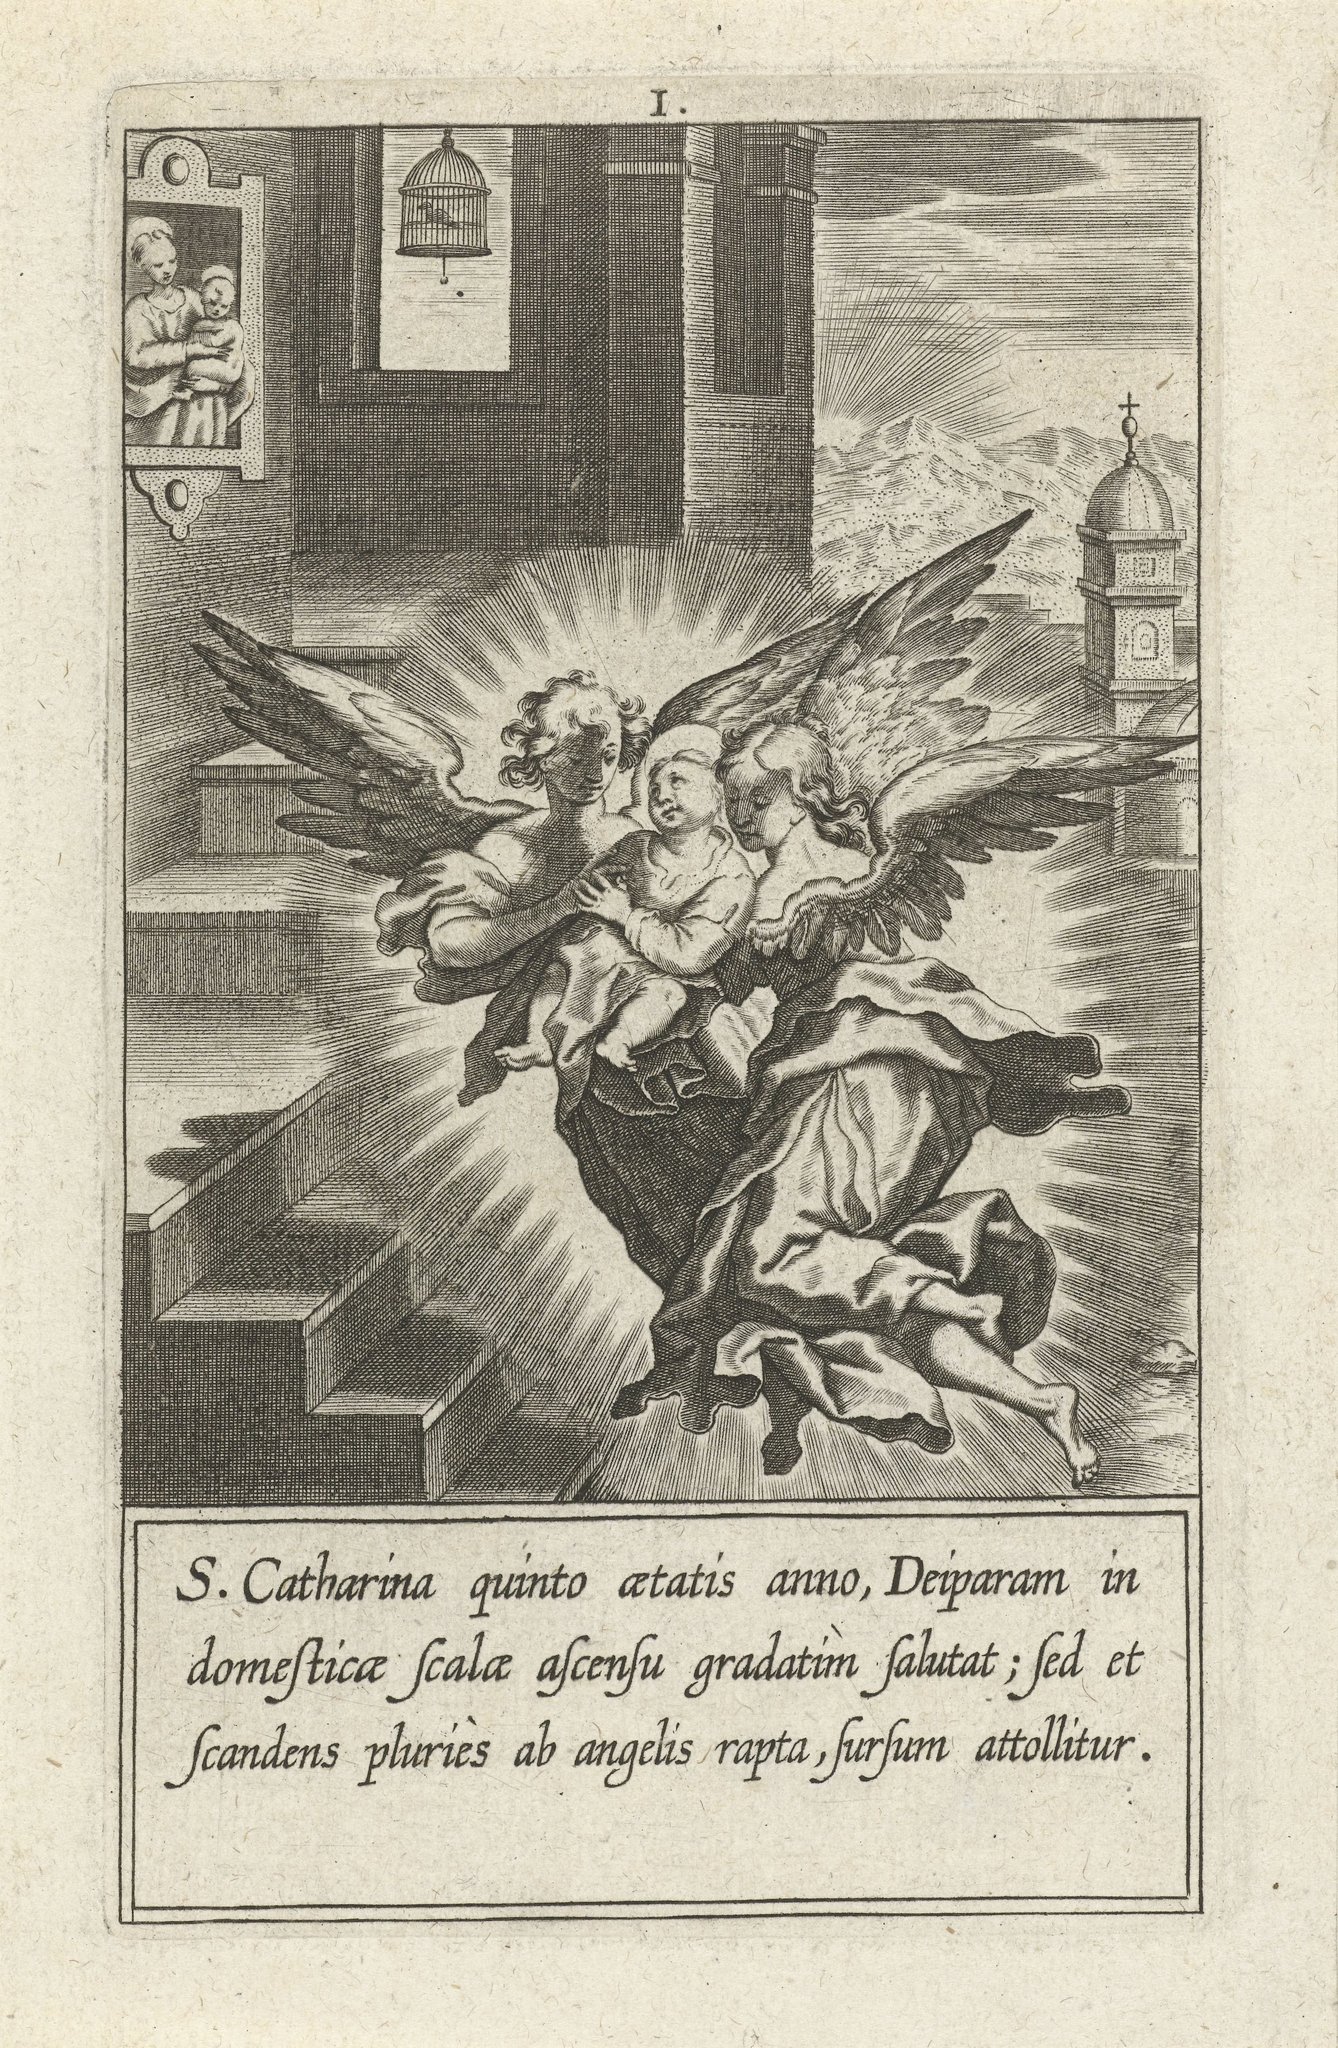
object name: print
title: Het leven van de H. Catharina van Siena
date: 1603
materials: paper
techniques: engraving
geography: antwerp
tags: the virgin and dominican tertiary, catherine of siena; possible attributes: book, cross, crown of thorns, crucifix, demon under foot, heart (with cross), lily, plague-stricken, ring, rosary, stigmata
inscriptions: collector's mark: Lugt 2228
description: De vijfjarige Catharina wordt door twee engelen opgetild en de trap in haar ouderlijk huis opgedragen. Deel van een serie over Catharina van Siena bestaande uit een titelprent, een portret en 32 genummerde scènes uit haar leven.